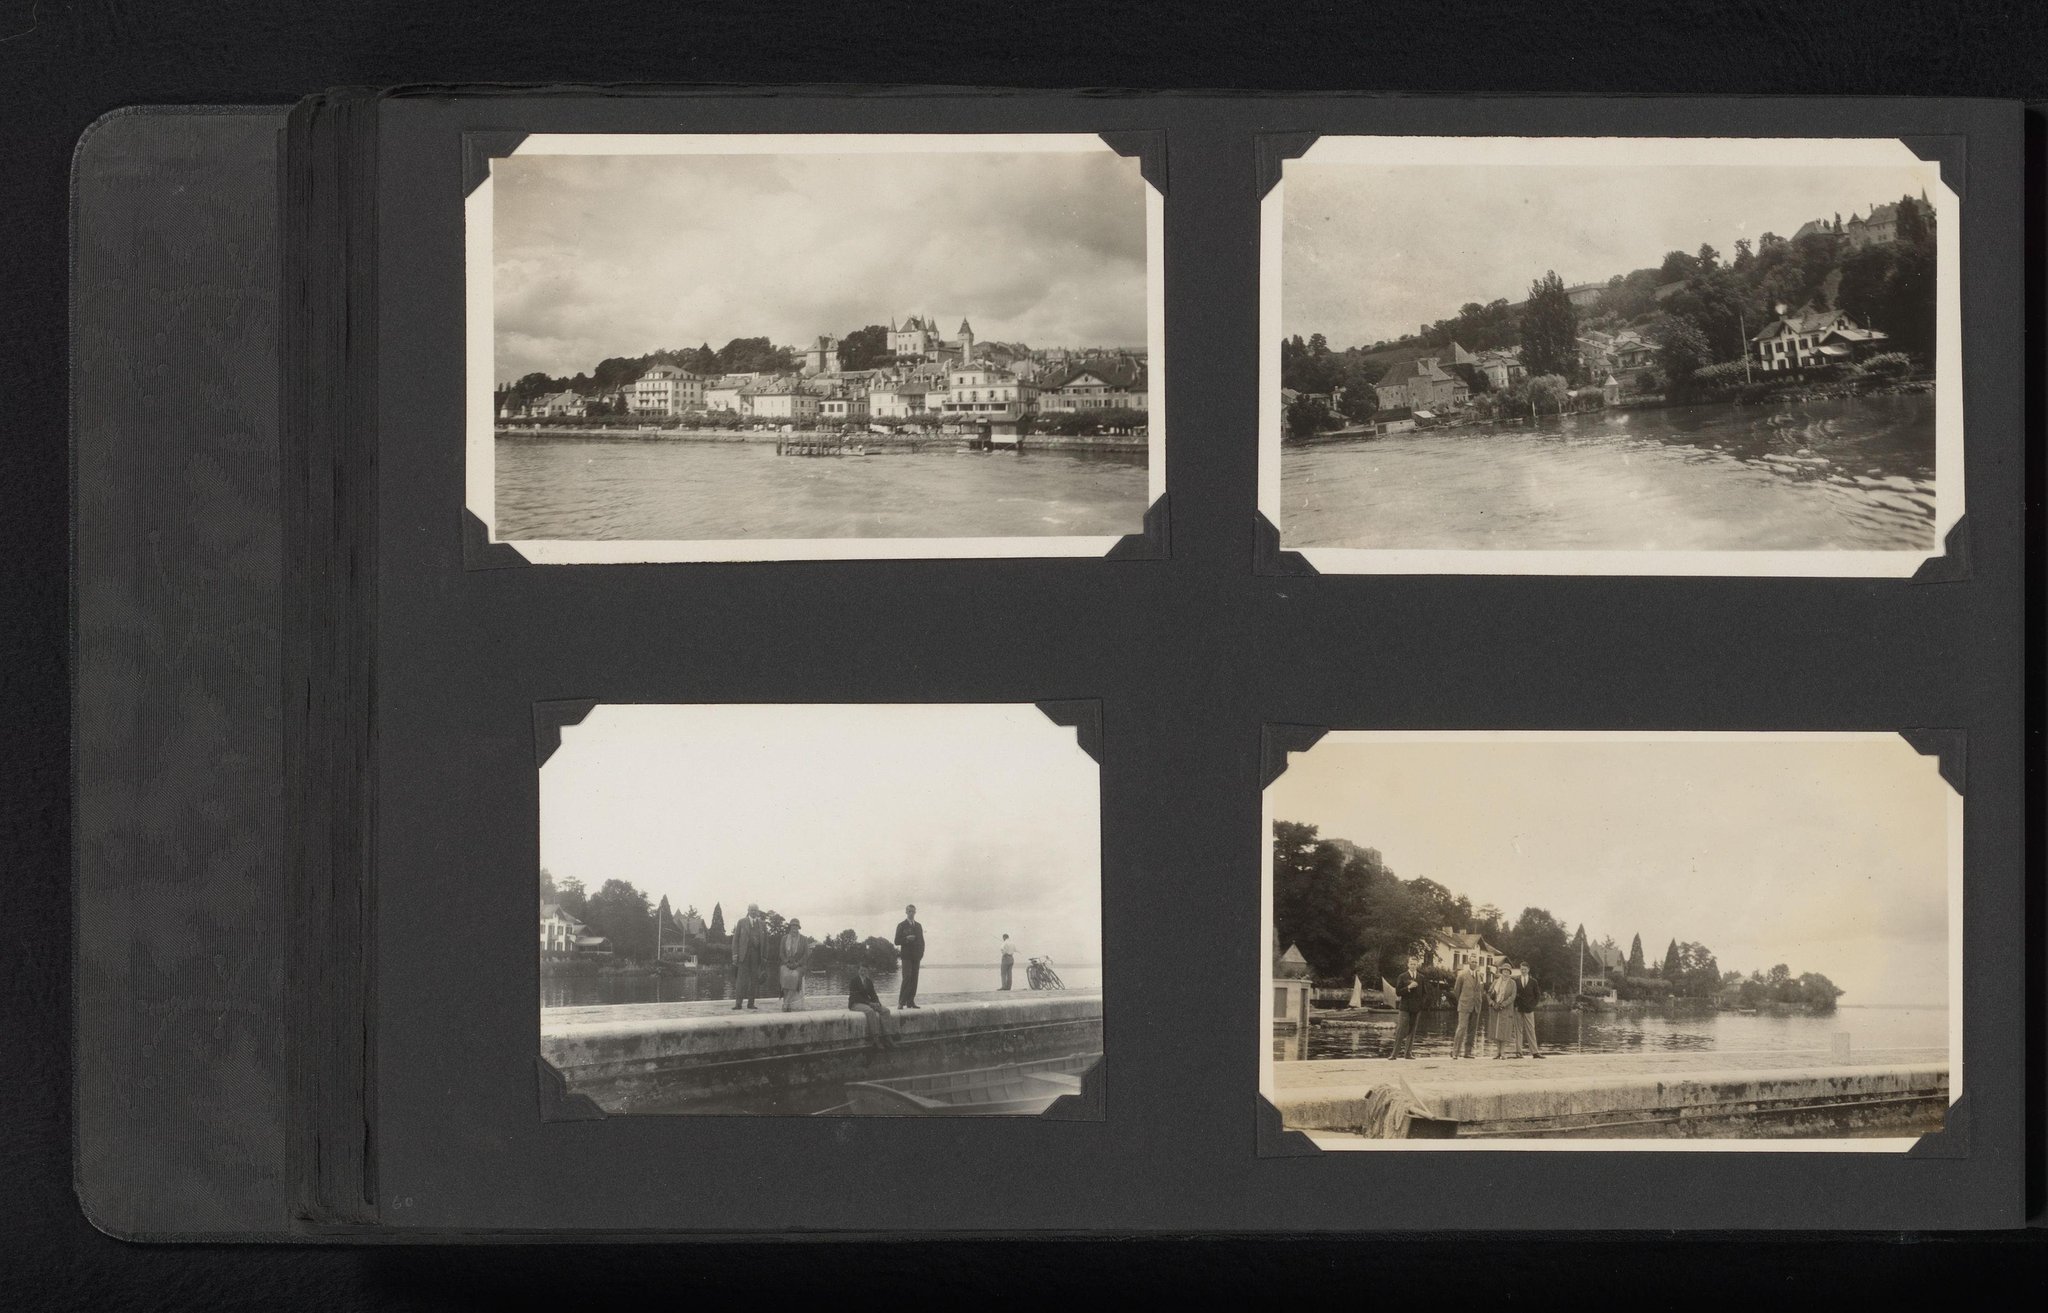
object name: photograph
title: Vier foto's van de familie Van den Berg in Genève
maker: hendrik herman van den berg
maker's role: amateurfotograaf, jurist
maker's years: 1875-1944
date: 1908-1929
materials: paper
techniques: gelatin silver print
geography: geneva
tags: hendrik herman van den berg, the hague, caroline louise van den berg-van den berg, carel frederik van den berg (cay), frank willem van den berg (1912-1998), the family travelling, on holiday, city-view in general; 'veduta', lake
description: Deze foto's maken deel uit van een album.